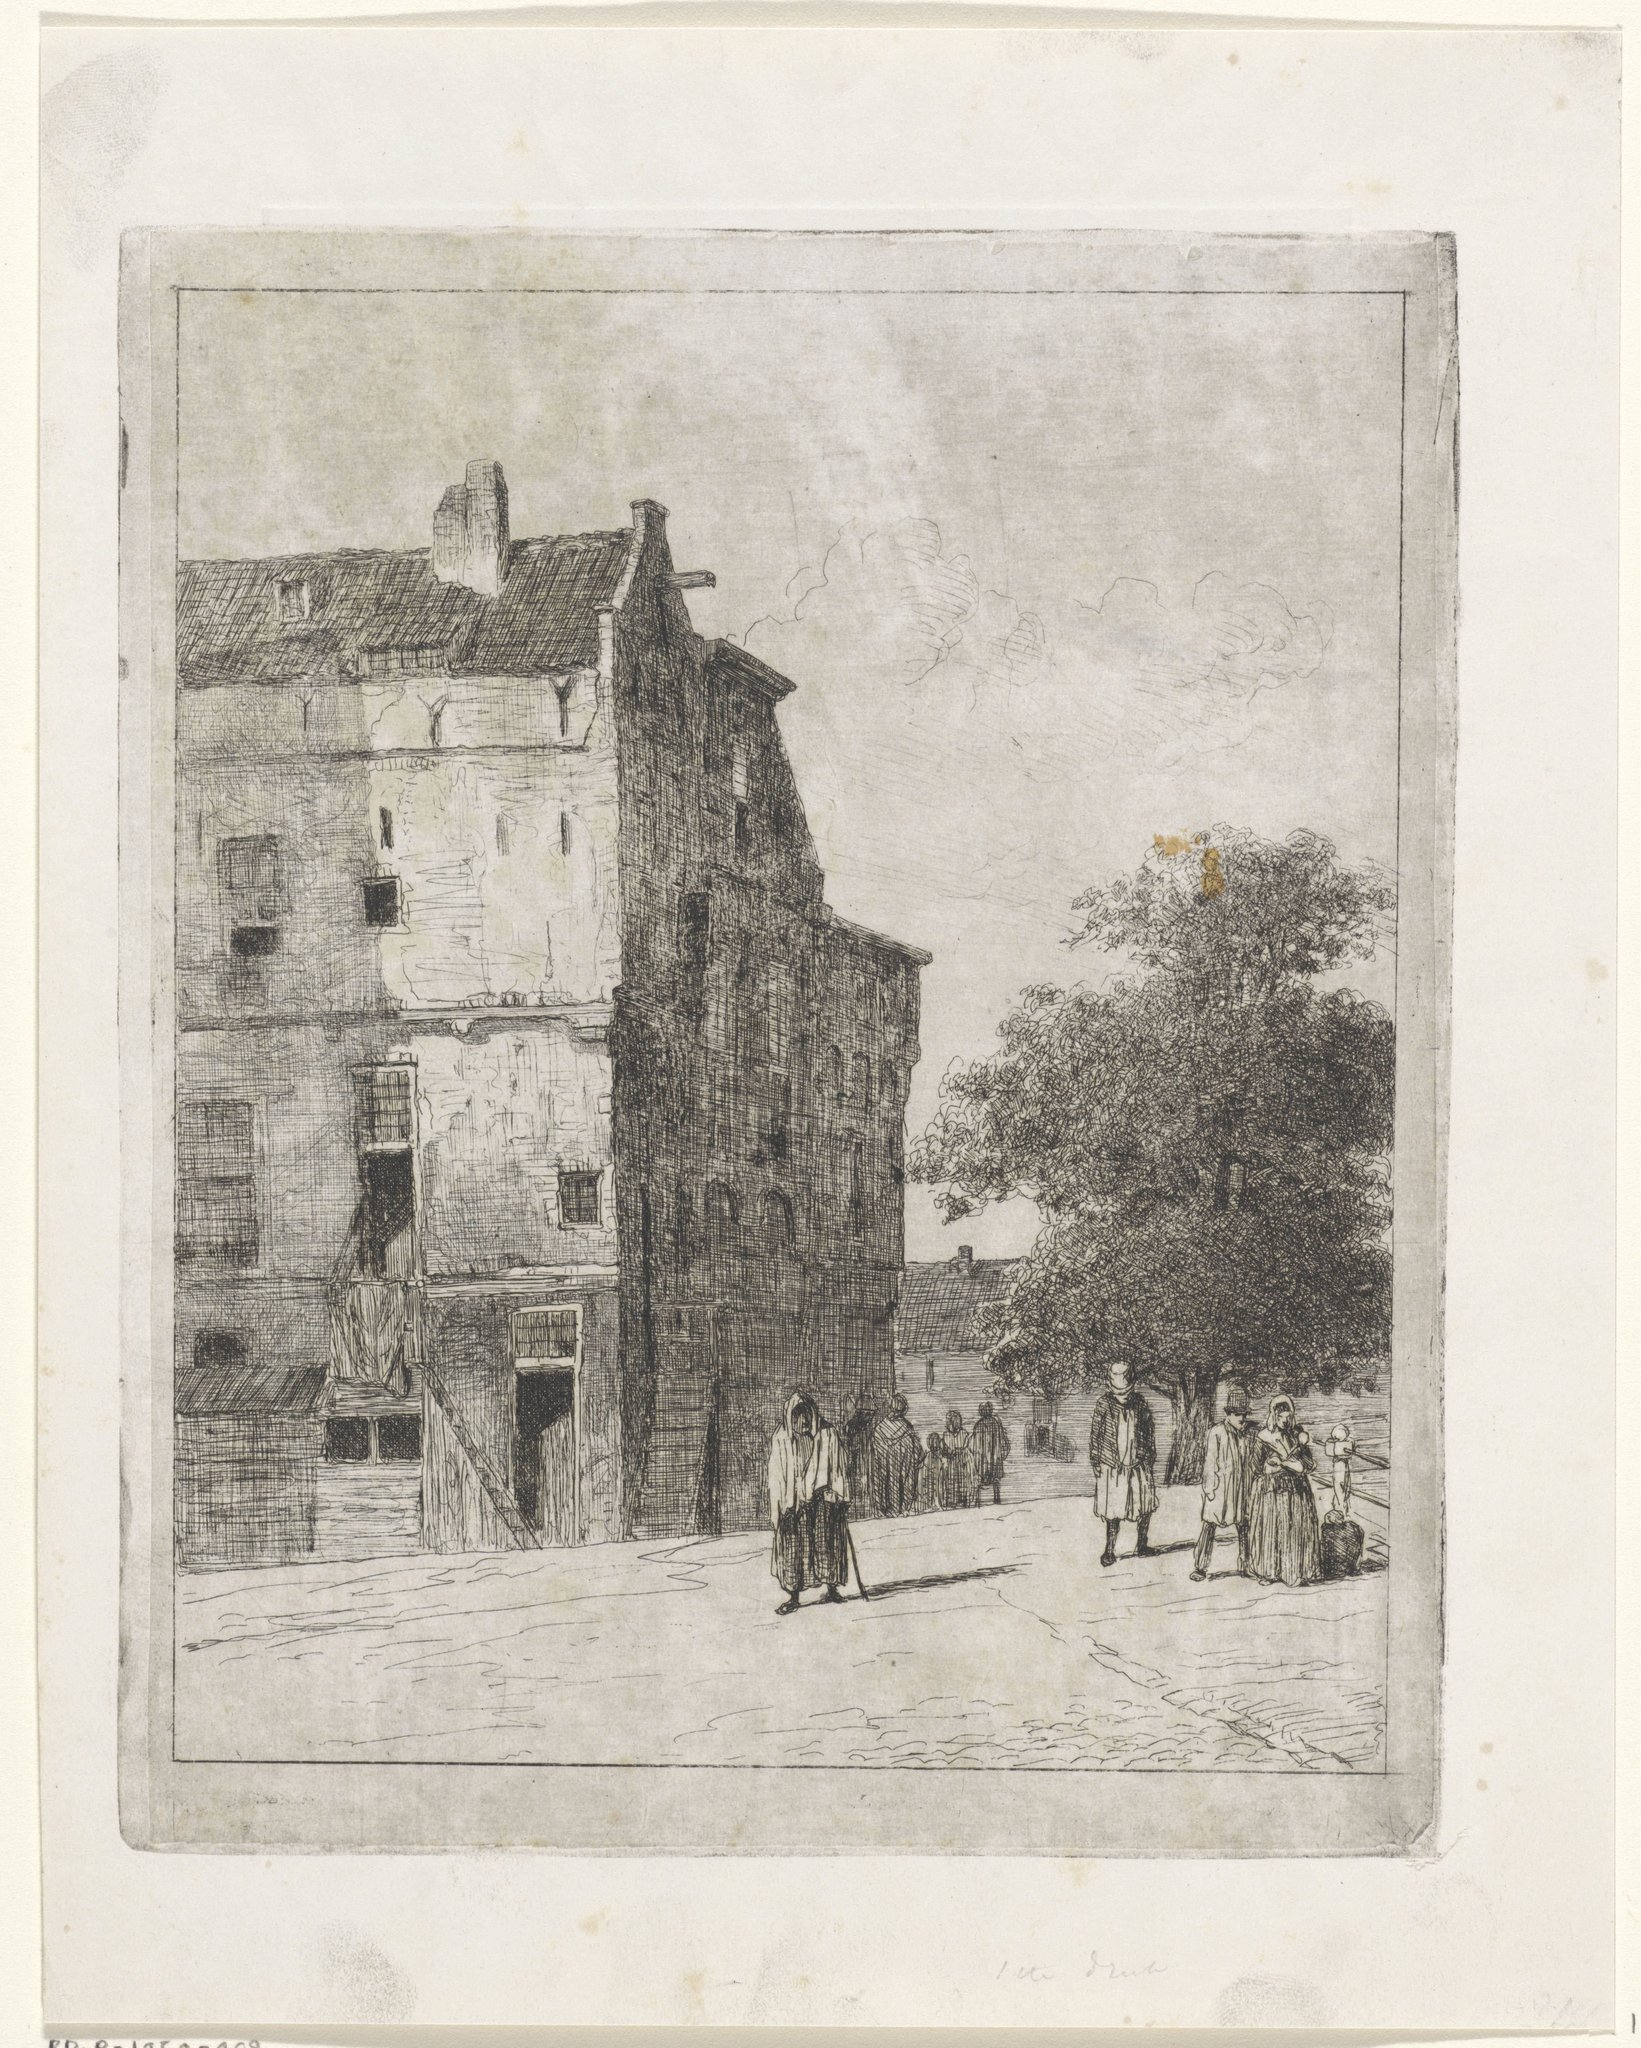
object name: print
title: Gezicht op een straat te Amsterdam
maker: jan weissenbruch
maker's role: painter, print maker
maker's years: 1822-1880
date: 1849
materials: paper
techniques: etching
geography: amsterdam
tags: urban housing, city-view, and landscape with man-made constructions, trees, adult woman, adult man, walking, amsterdam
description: Enkele figuren lopen over straat. Links en in de verte staan een paar huizen. Rechts zijn bomen te zien.